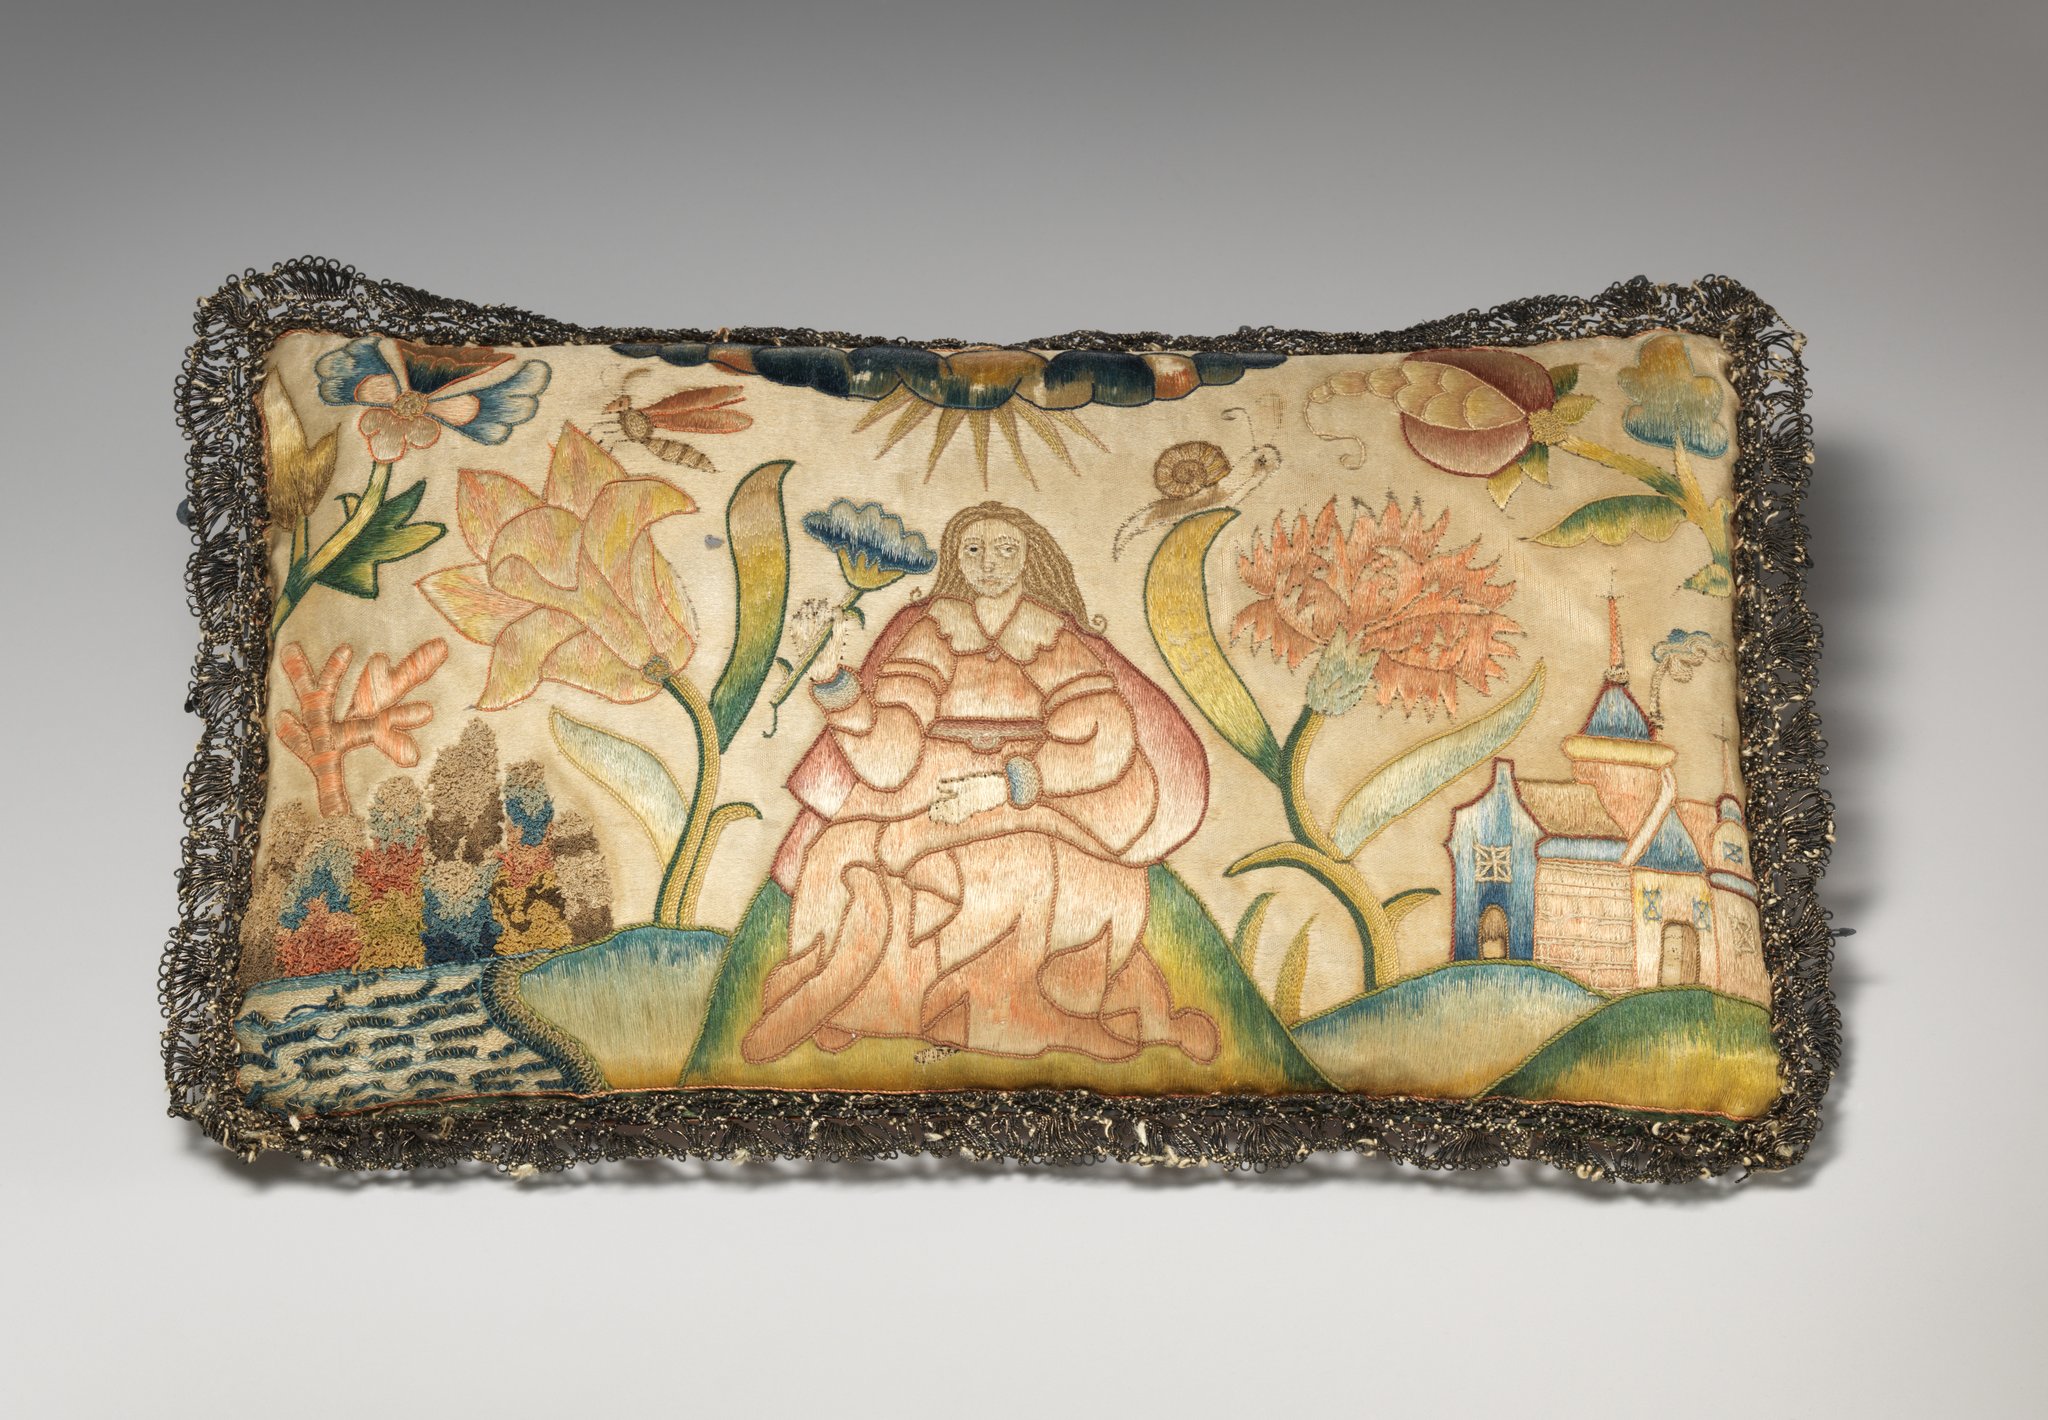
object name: cushion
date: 1634-1666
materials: textile, silk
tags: women,flowers